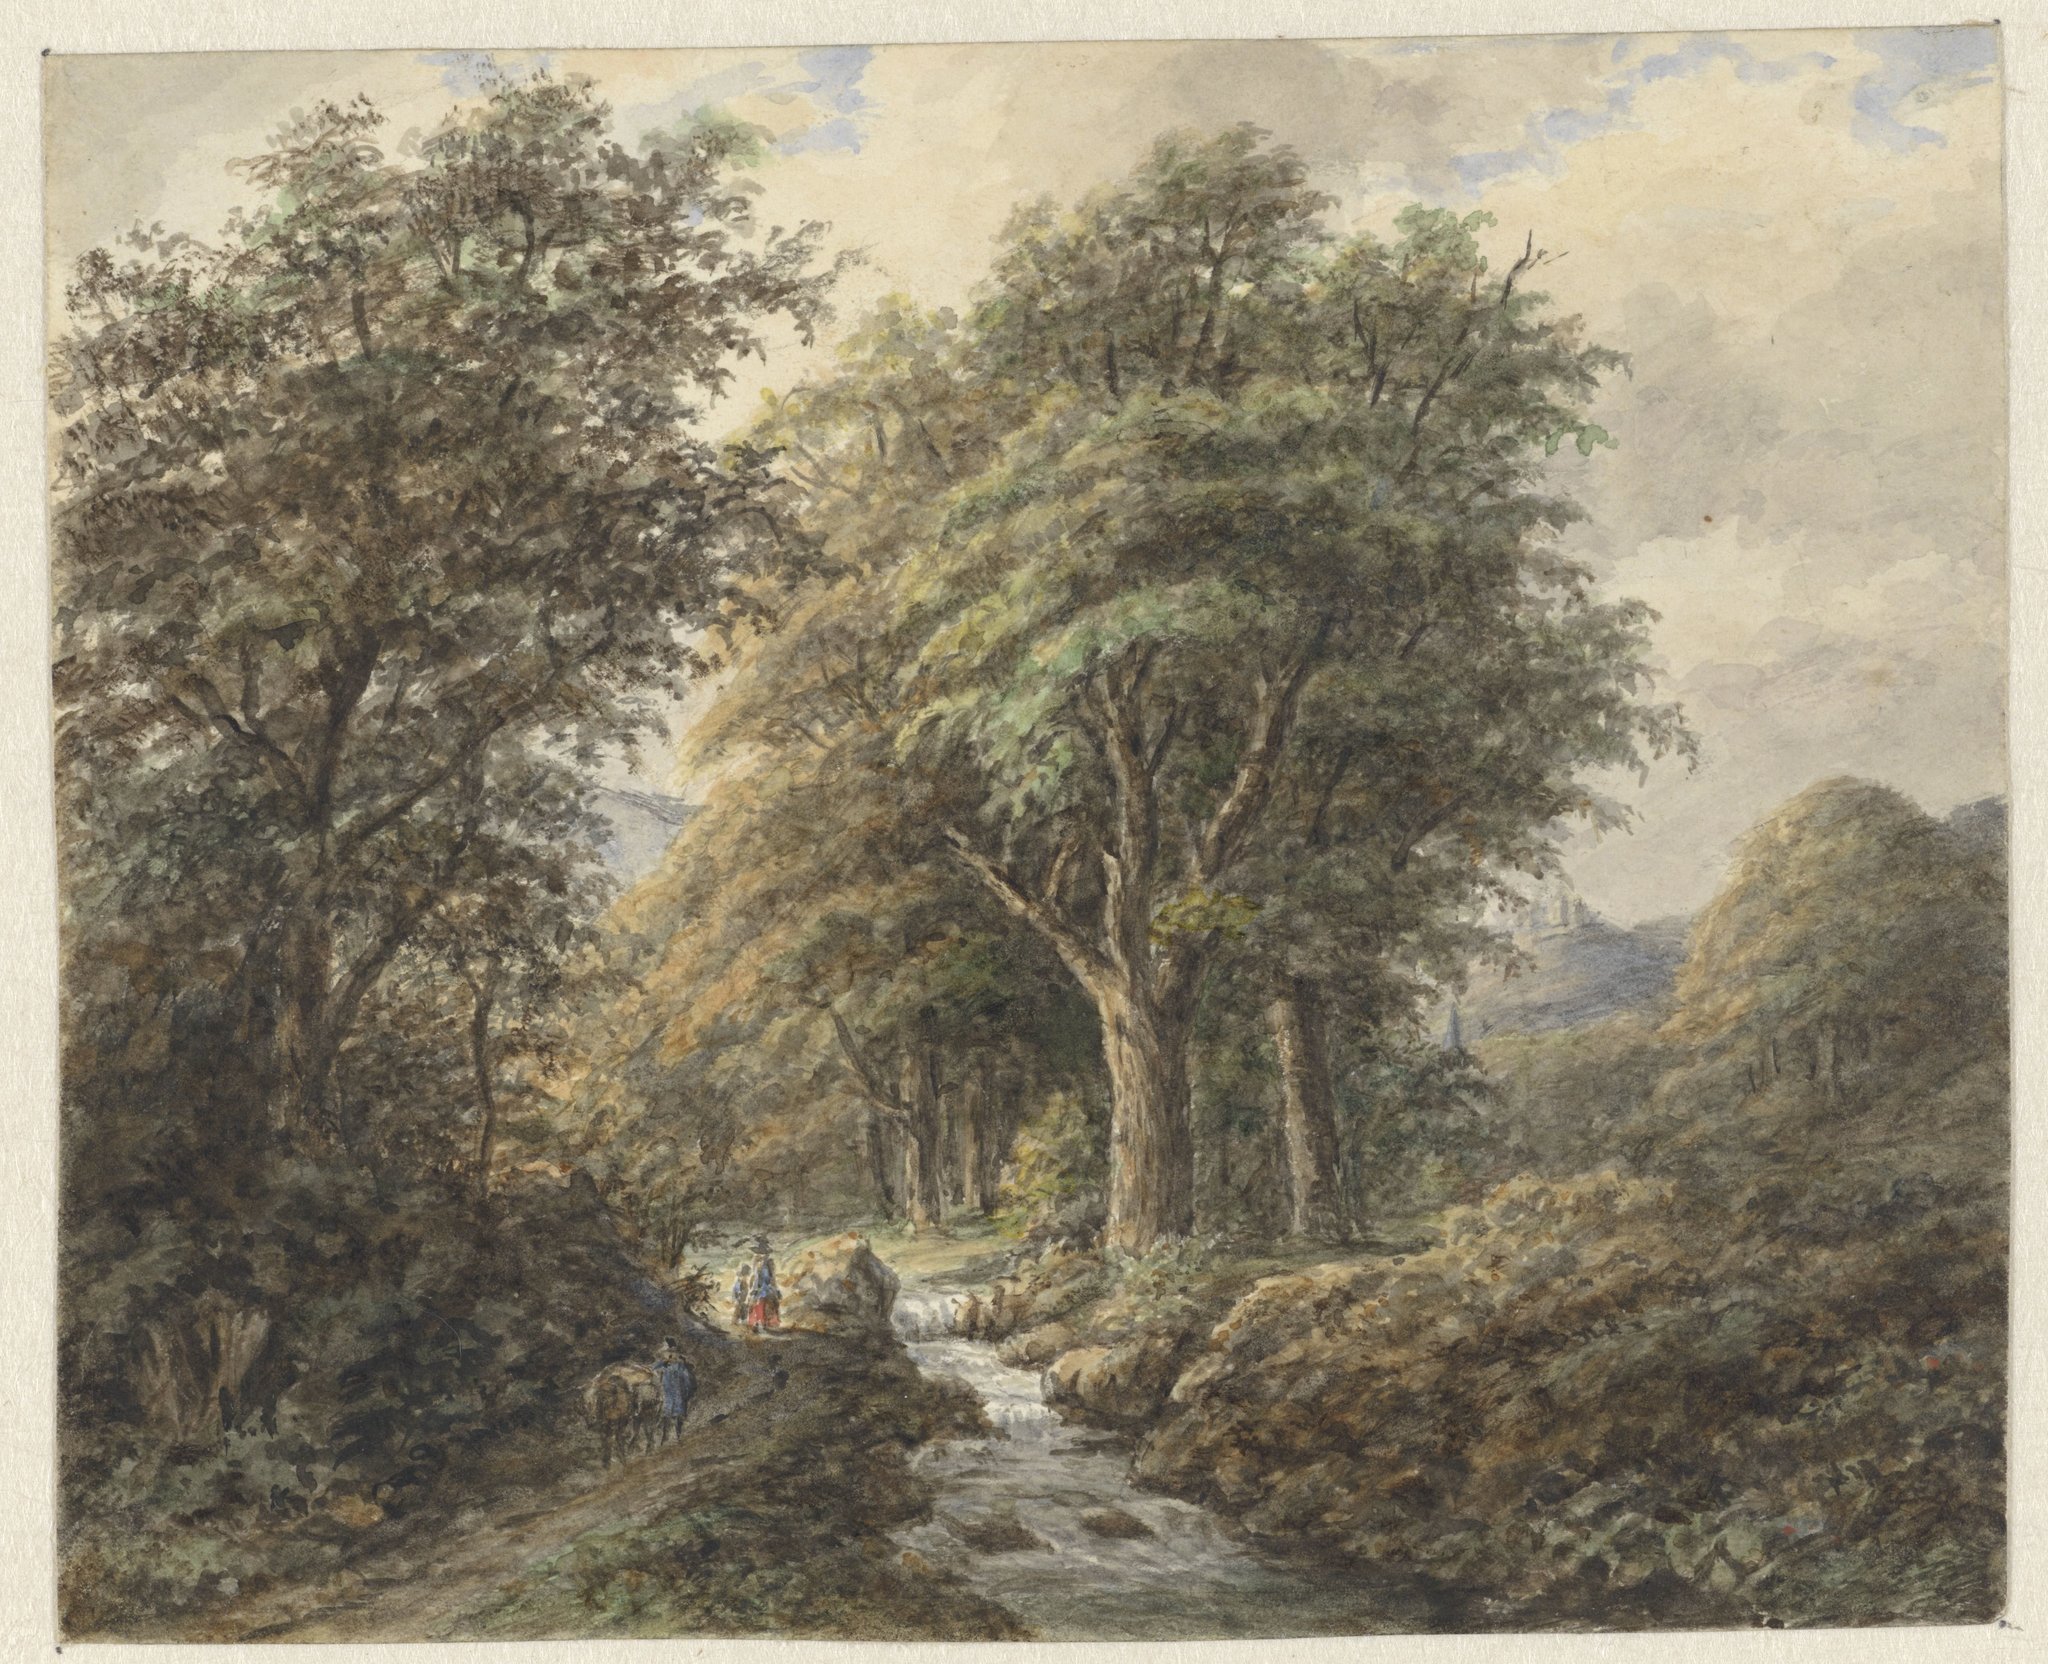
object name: drawing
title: Landschap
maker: matthijs maris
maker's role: draughtsman, painter, print maker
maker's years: 1839-1917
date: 1849-1917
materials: paper, watercolor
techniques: brush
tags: forest, wood